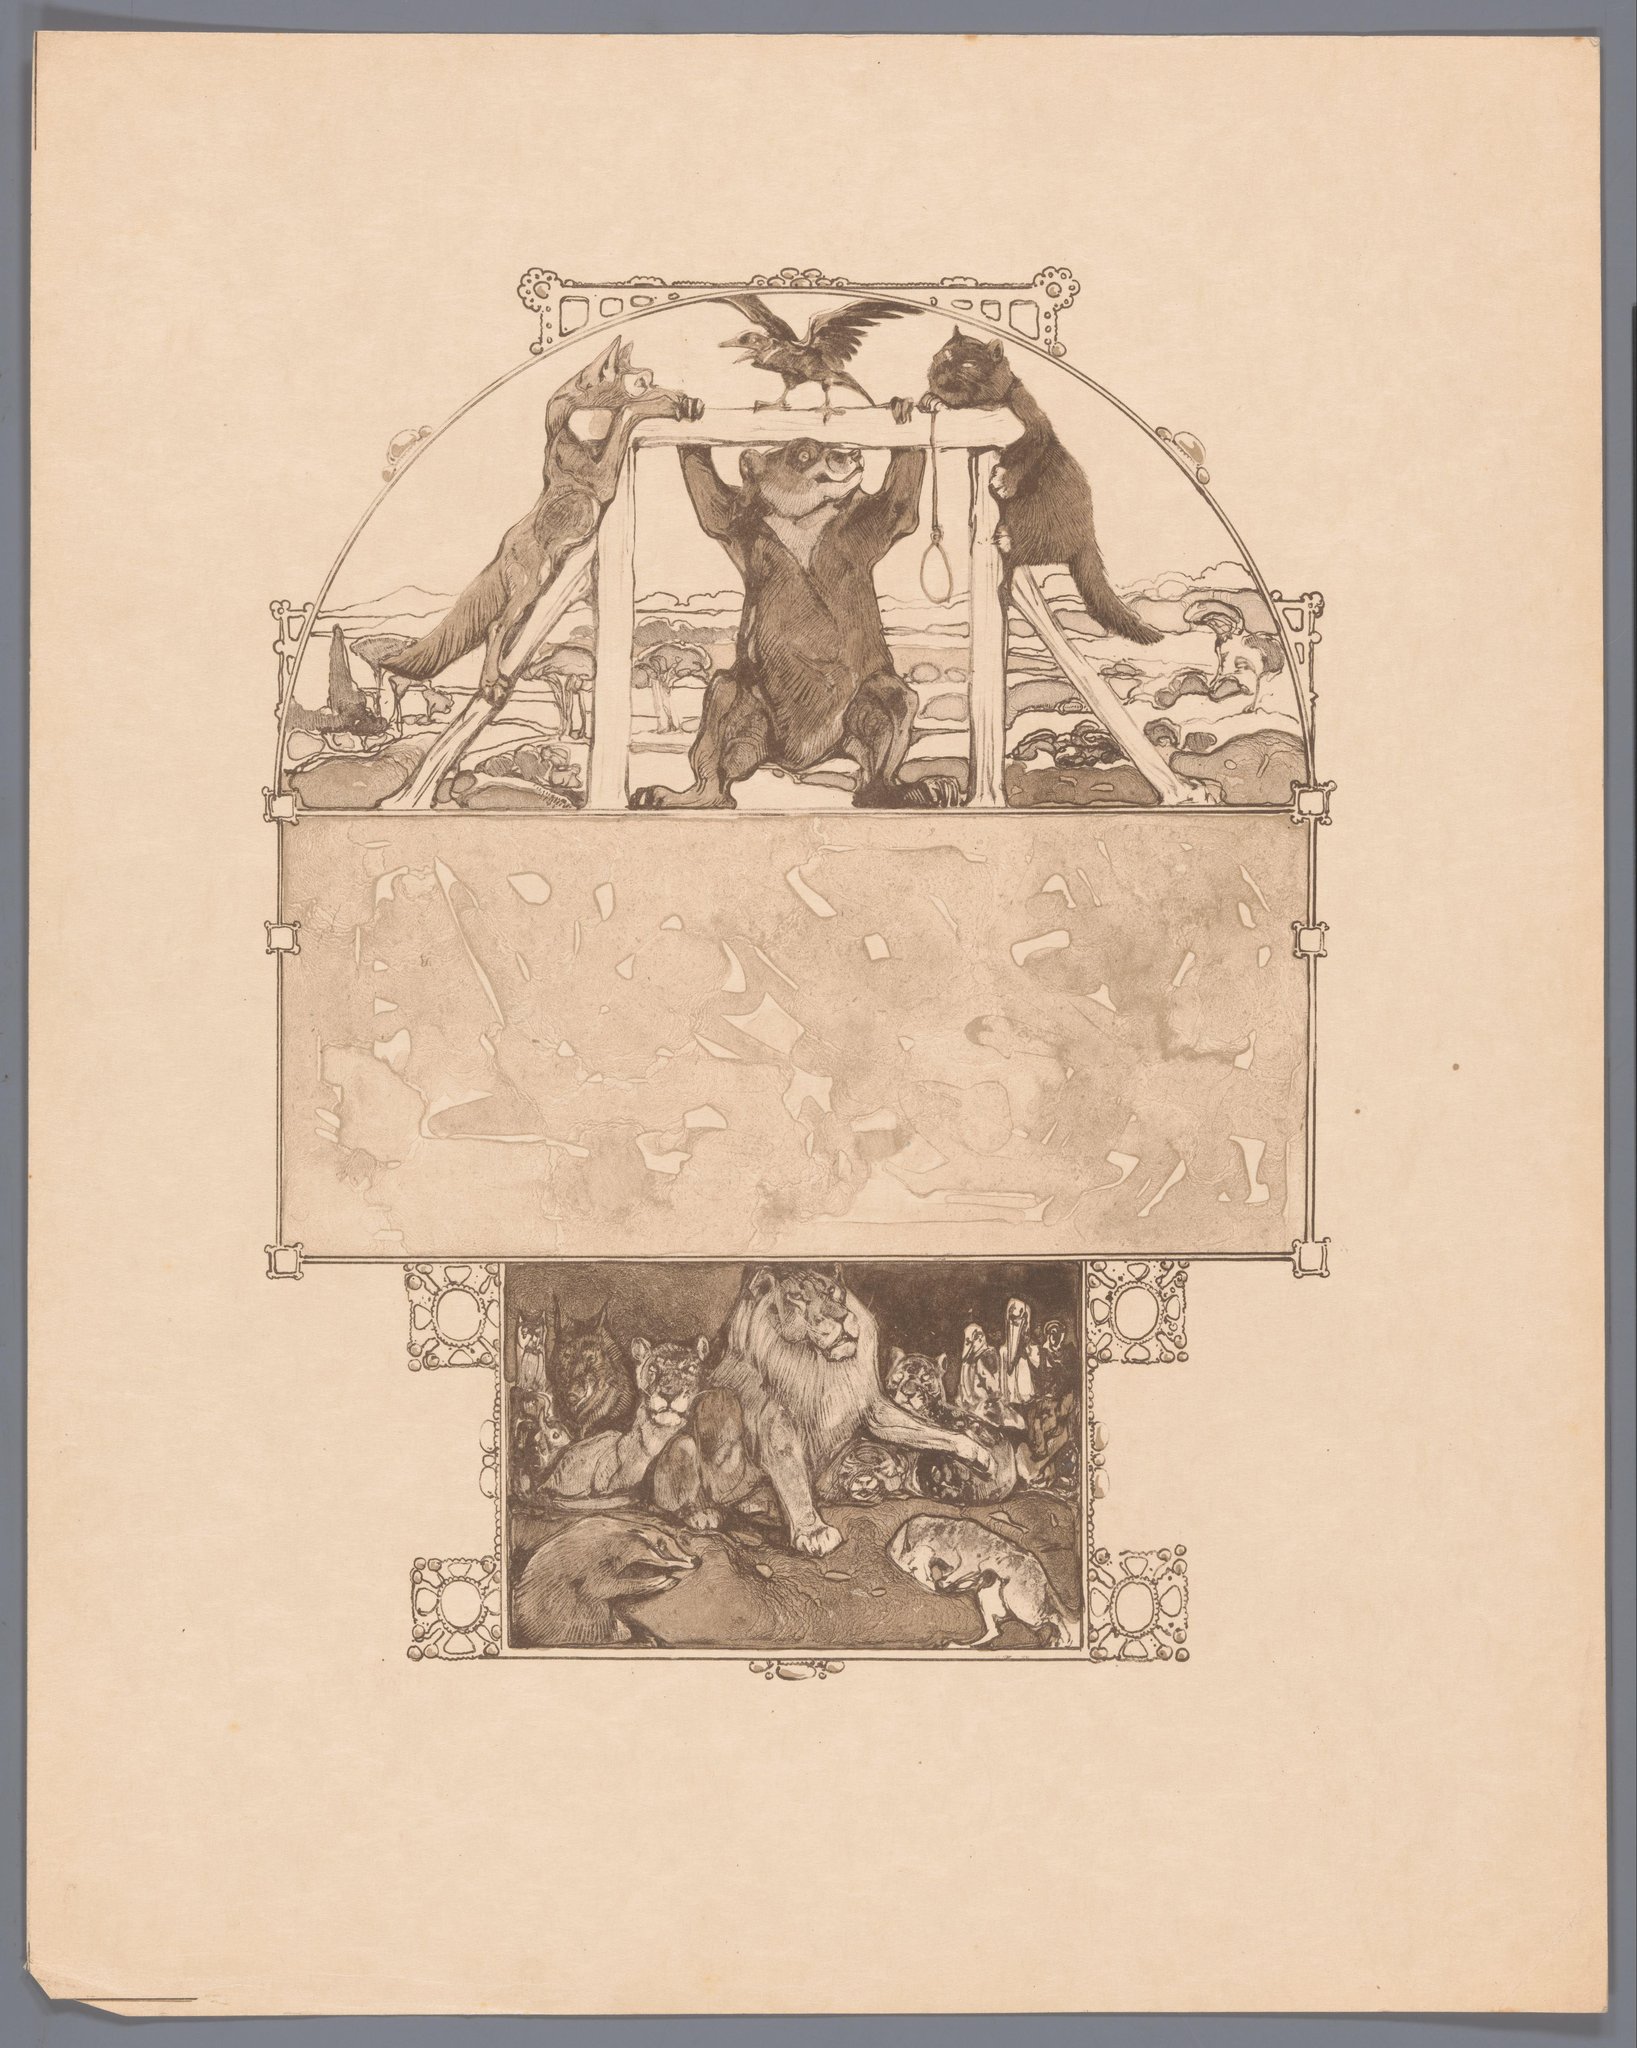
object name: boekillustratie ontwerp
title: Vos (Reinaert), beer (Bruun), kat (Tybeert) en raaf (Tiecelijn) bij galg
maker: bernard willem wierink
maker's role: draughtsman, print maker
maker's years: 1856-1939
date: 1910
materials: paper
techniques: lithograph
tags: fable of reynard the fox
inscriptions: collector's mark: Lugt 2228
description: Ontwerp voor: Streuvels, Stijn (Frank Lateur). Reinaert de Vos naar verschillende uitgaven van het middeleeuwsche epos. Amsterdam: L.J. Veen, 1910.